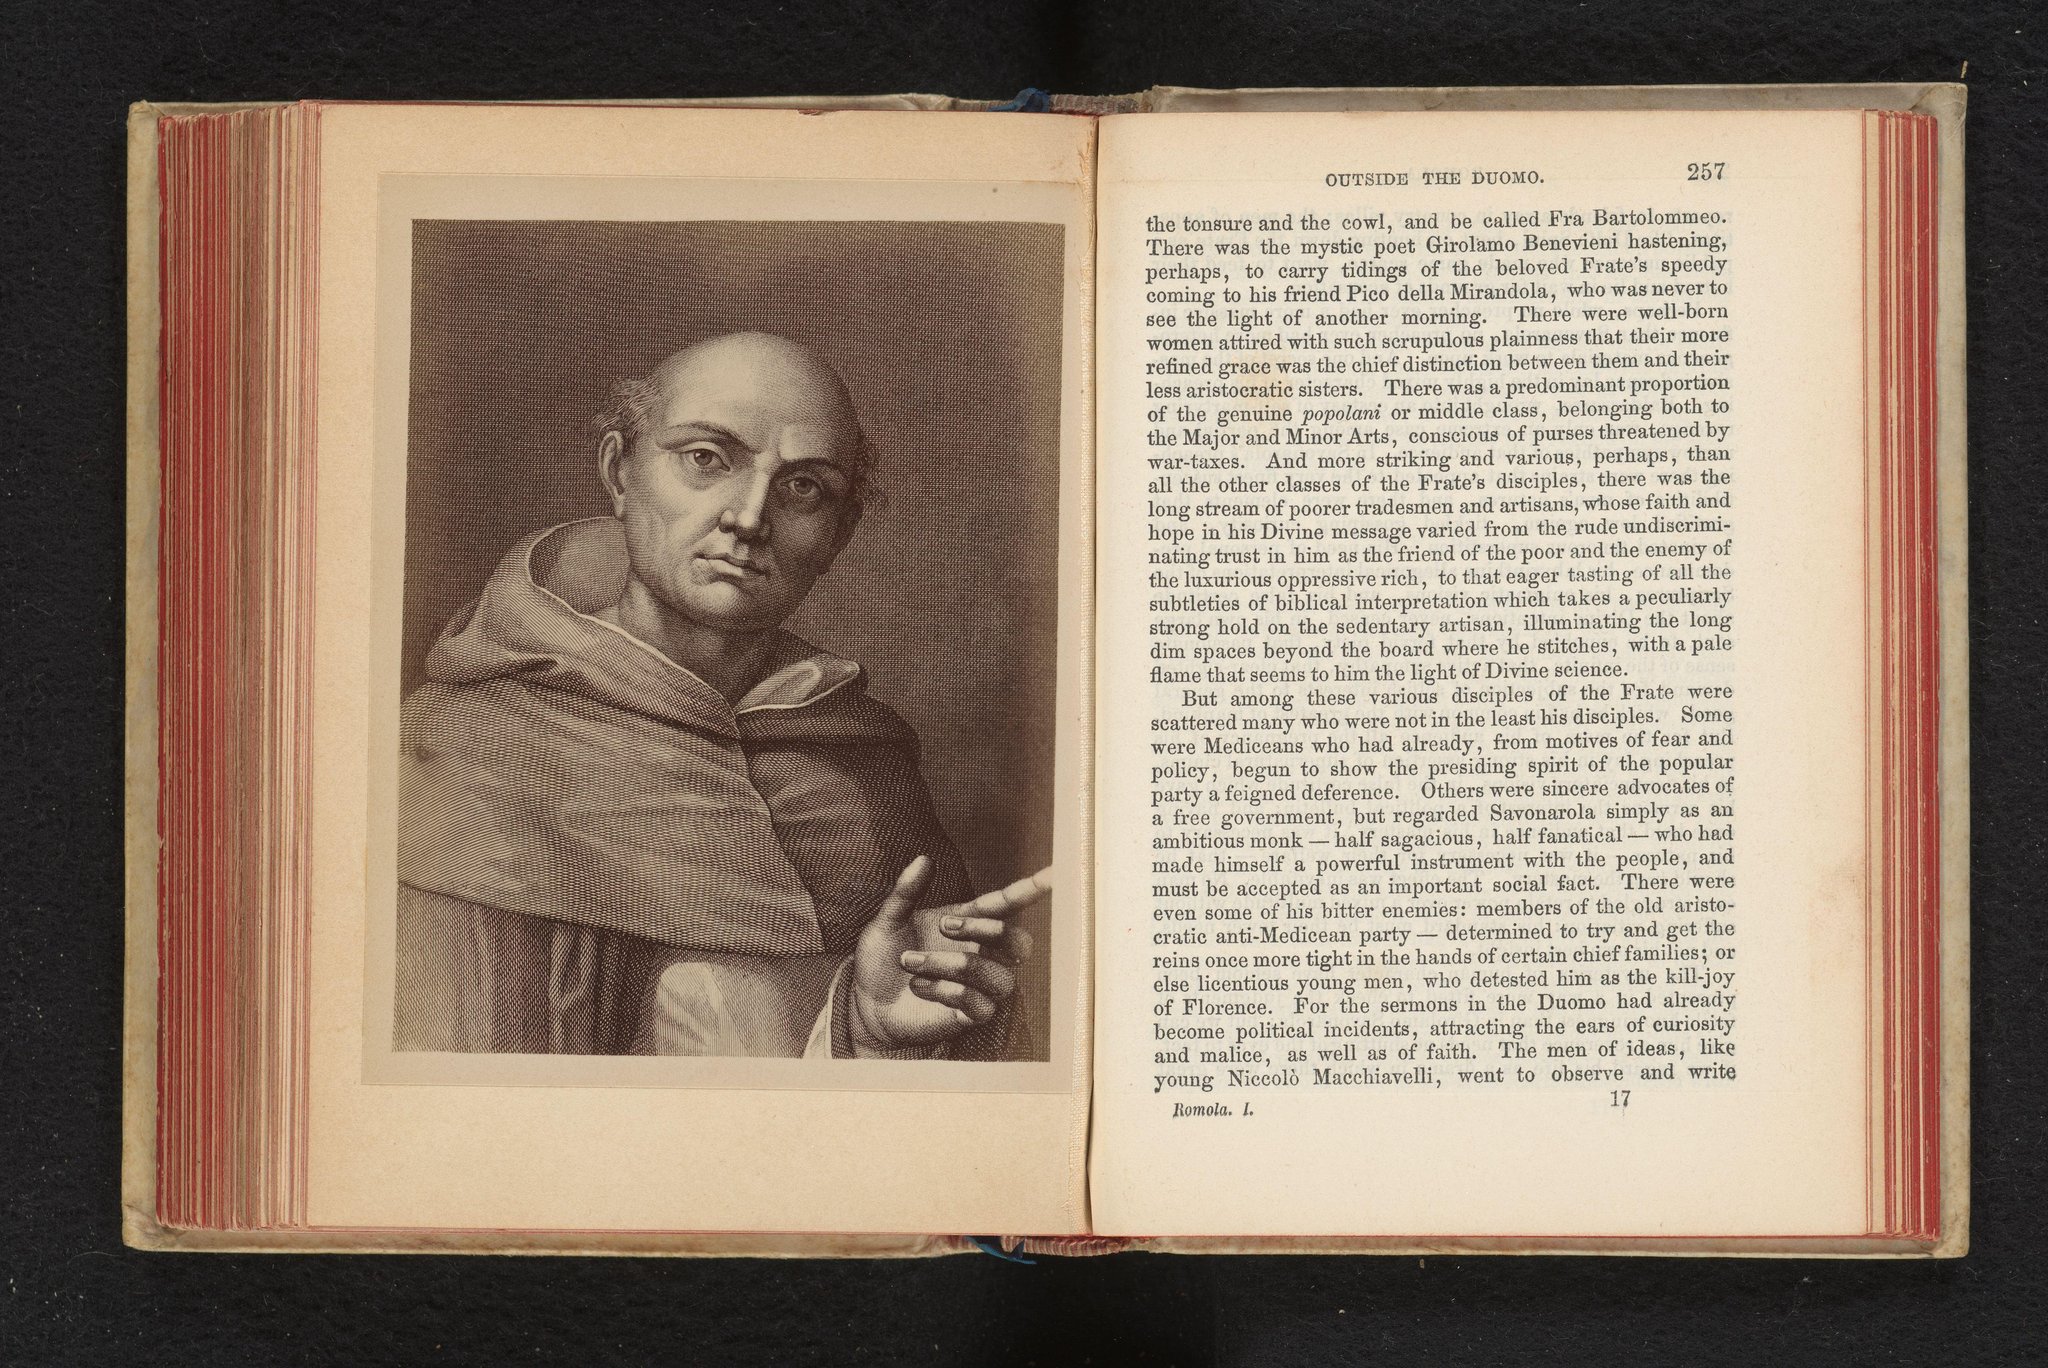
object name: photograph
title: Fotoreproductie van een prent van een portret van Fra Bartolommeo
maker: giacomo brogi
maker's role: fotograaf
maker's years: 1822-1881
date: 1858-1863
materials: paper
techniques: albumen print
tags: draughtsman, bartolommeo (fra), historical persons, portrait, self-portrait of artist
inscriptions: name: ‘Brogi’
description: Foto op ongenummerde pagina tegenover pagina 257.